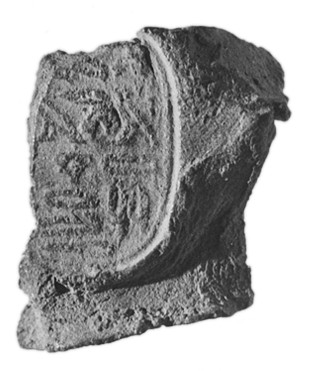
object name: sealing fragment, private name and title, hershy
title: Sealing fragment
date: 1850-1640 BCE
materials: clay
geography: egypt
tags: hieroglyphs